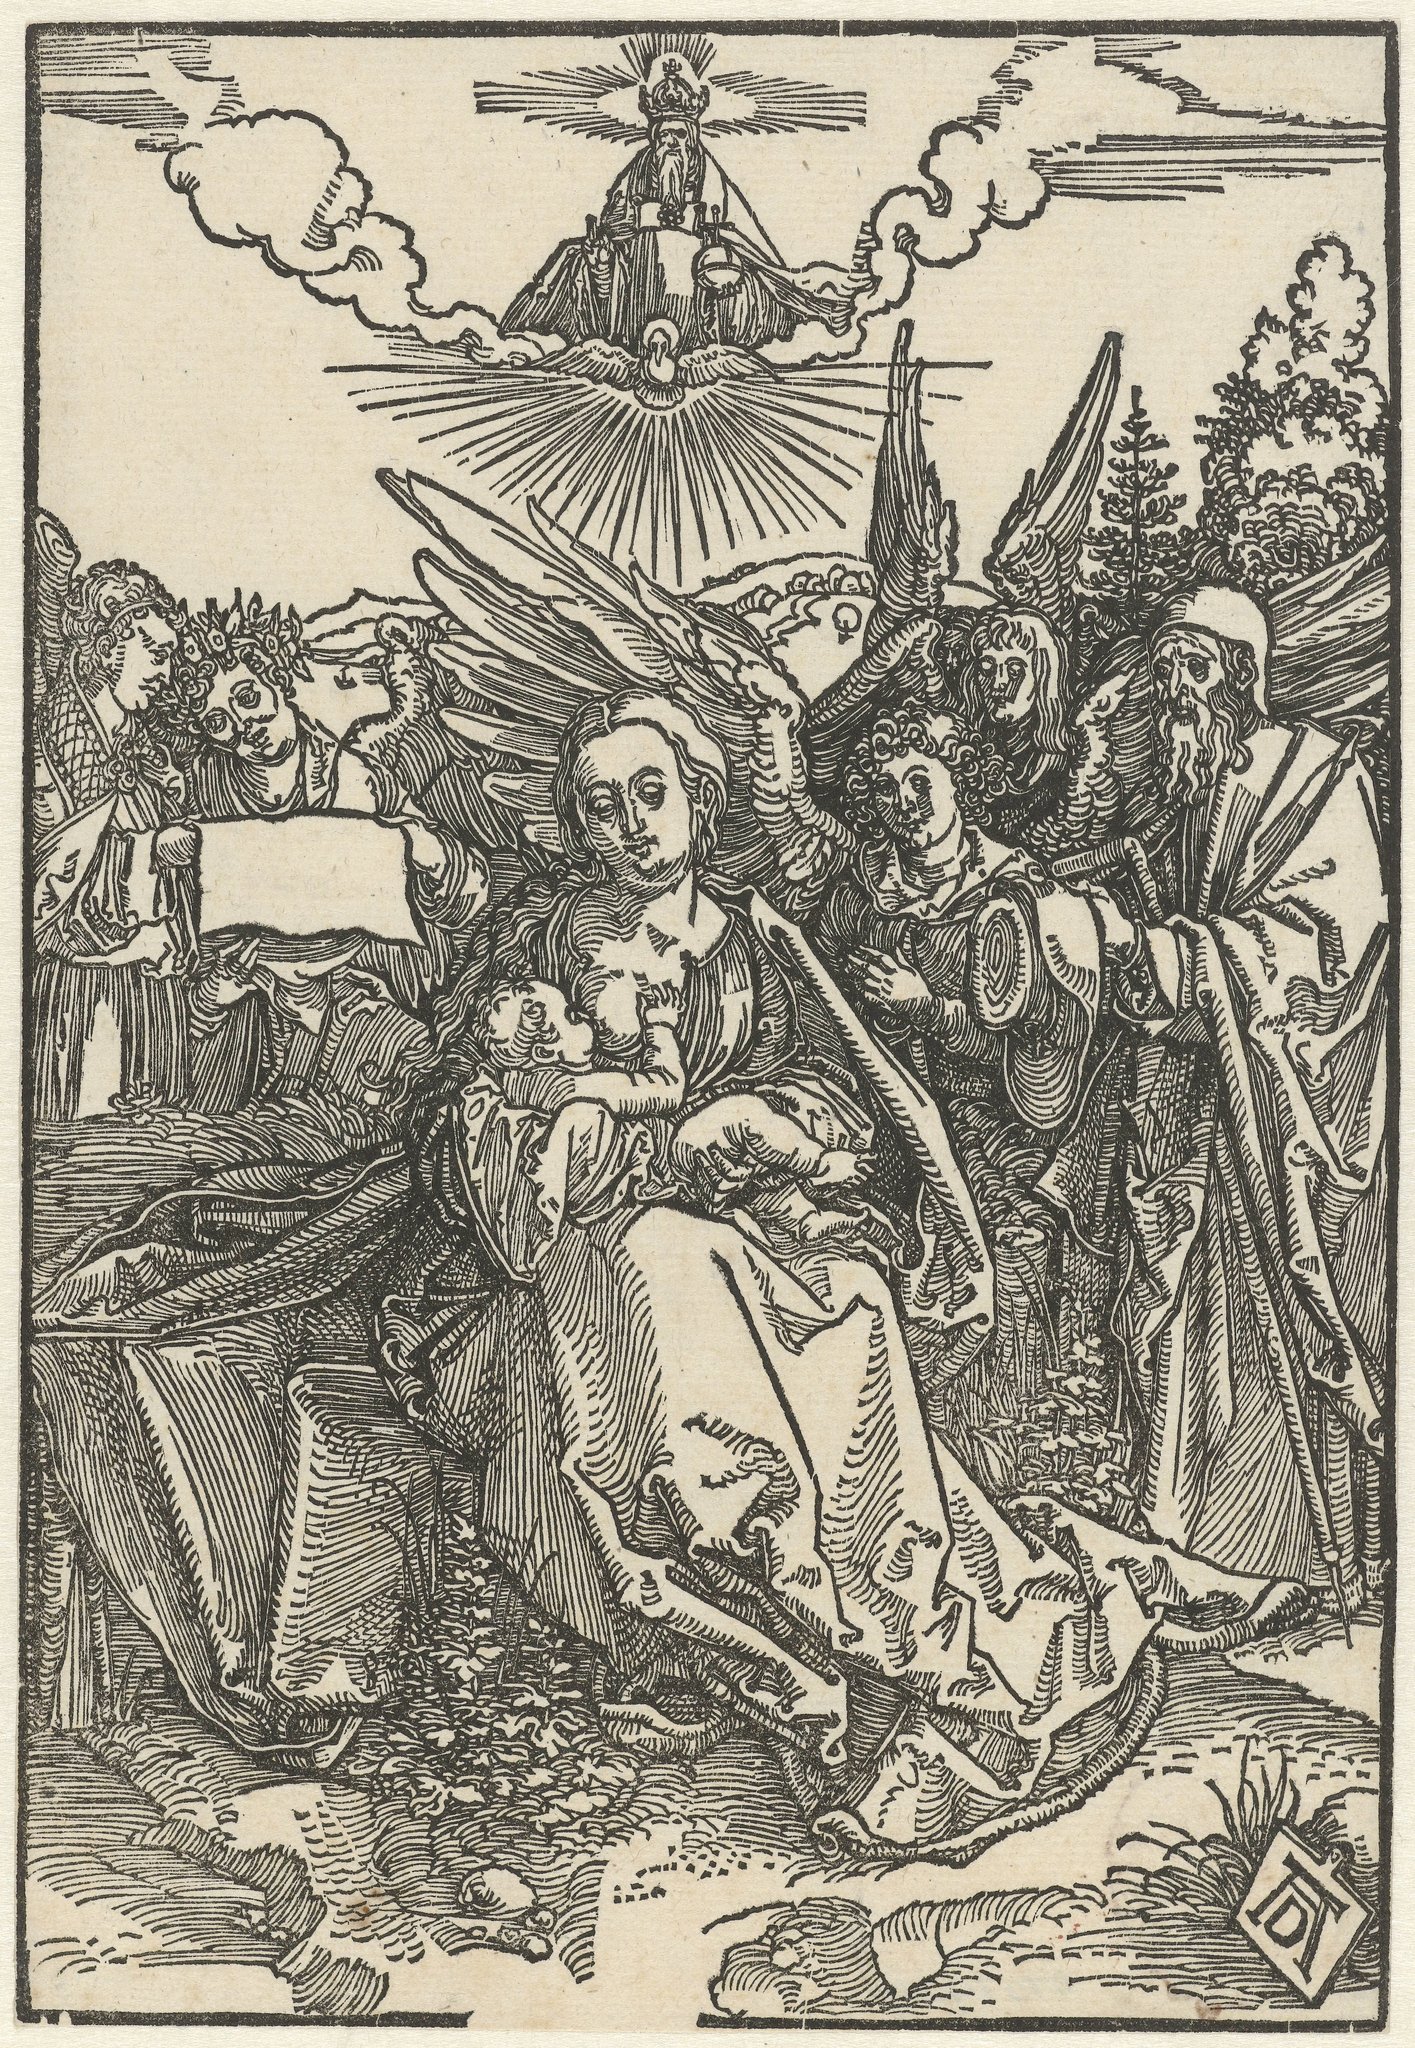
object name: print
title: De Heilige Familie met vijf engelen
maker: albrecht dürer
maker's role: draughtsman, painter, print maker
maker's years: 1471-1528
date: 1503-1504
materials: paper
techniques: woodcut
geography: nuremberg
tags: holy family, and derived representations, christ-child suckling, or beginning to suckle, e.g. mary uncovering her breast ~ madonna-representations, angels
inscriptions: collector's mark: Lugt 240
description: Maria geeft het Christuskind de borst, naast haar staat Jozef met zijn hoed in zijn handen. Om de Heilige Familie staan vijf engelen. Boven hen zijn God en de Heilige Geest (in de gedaante van een duif) te zien.